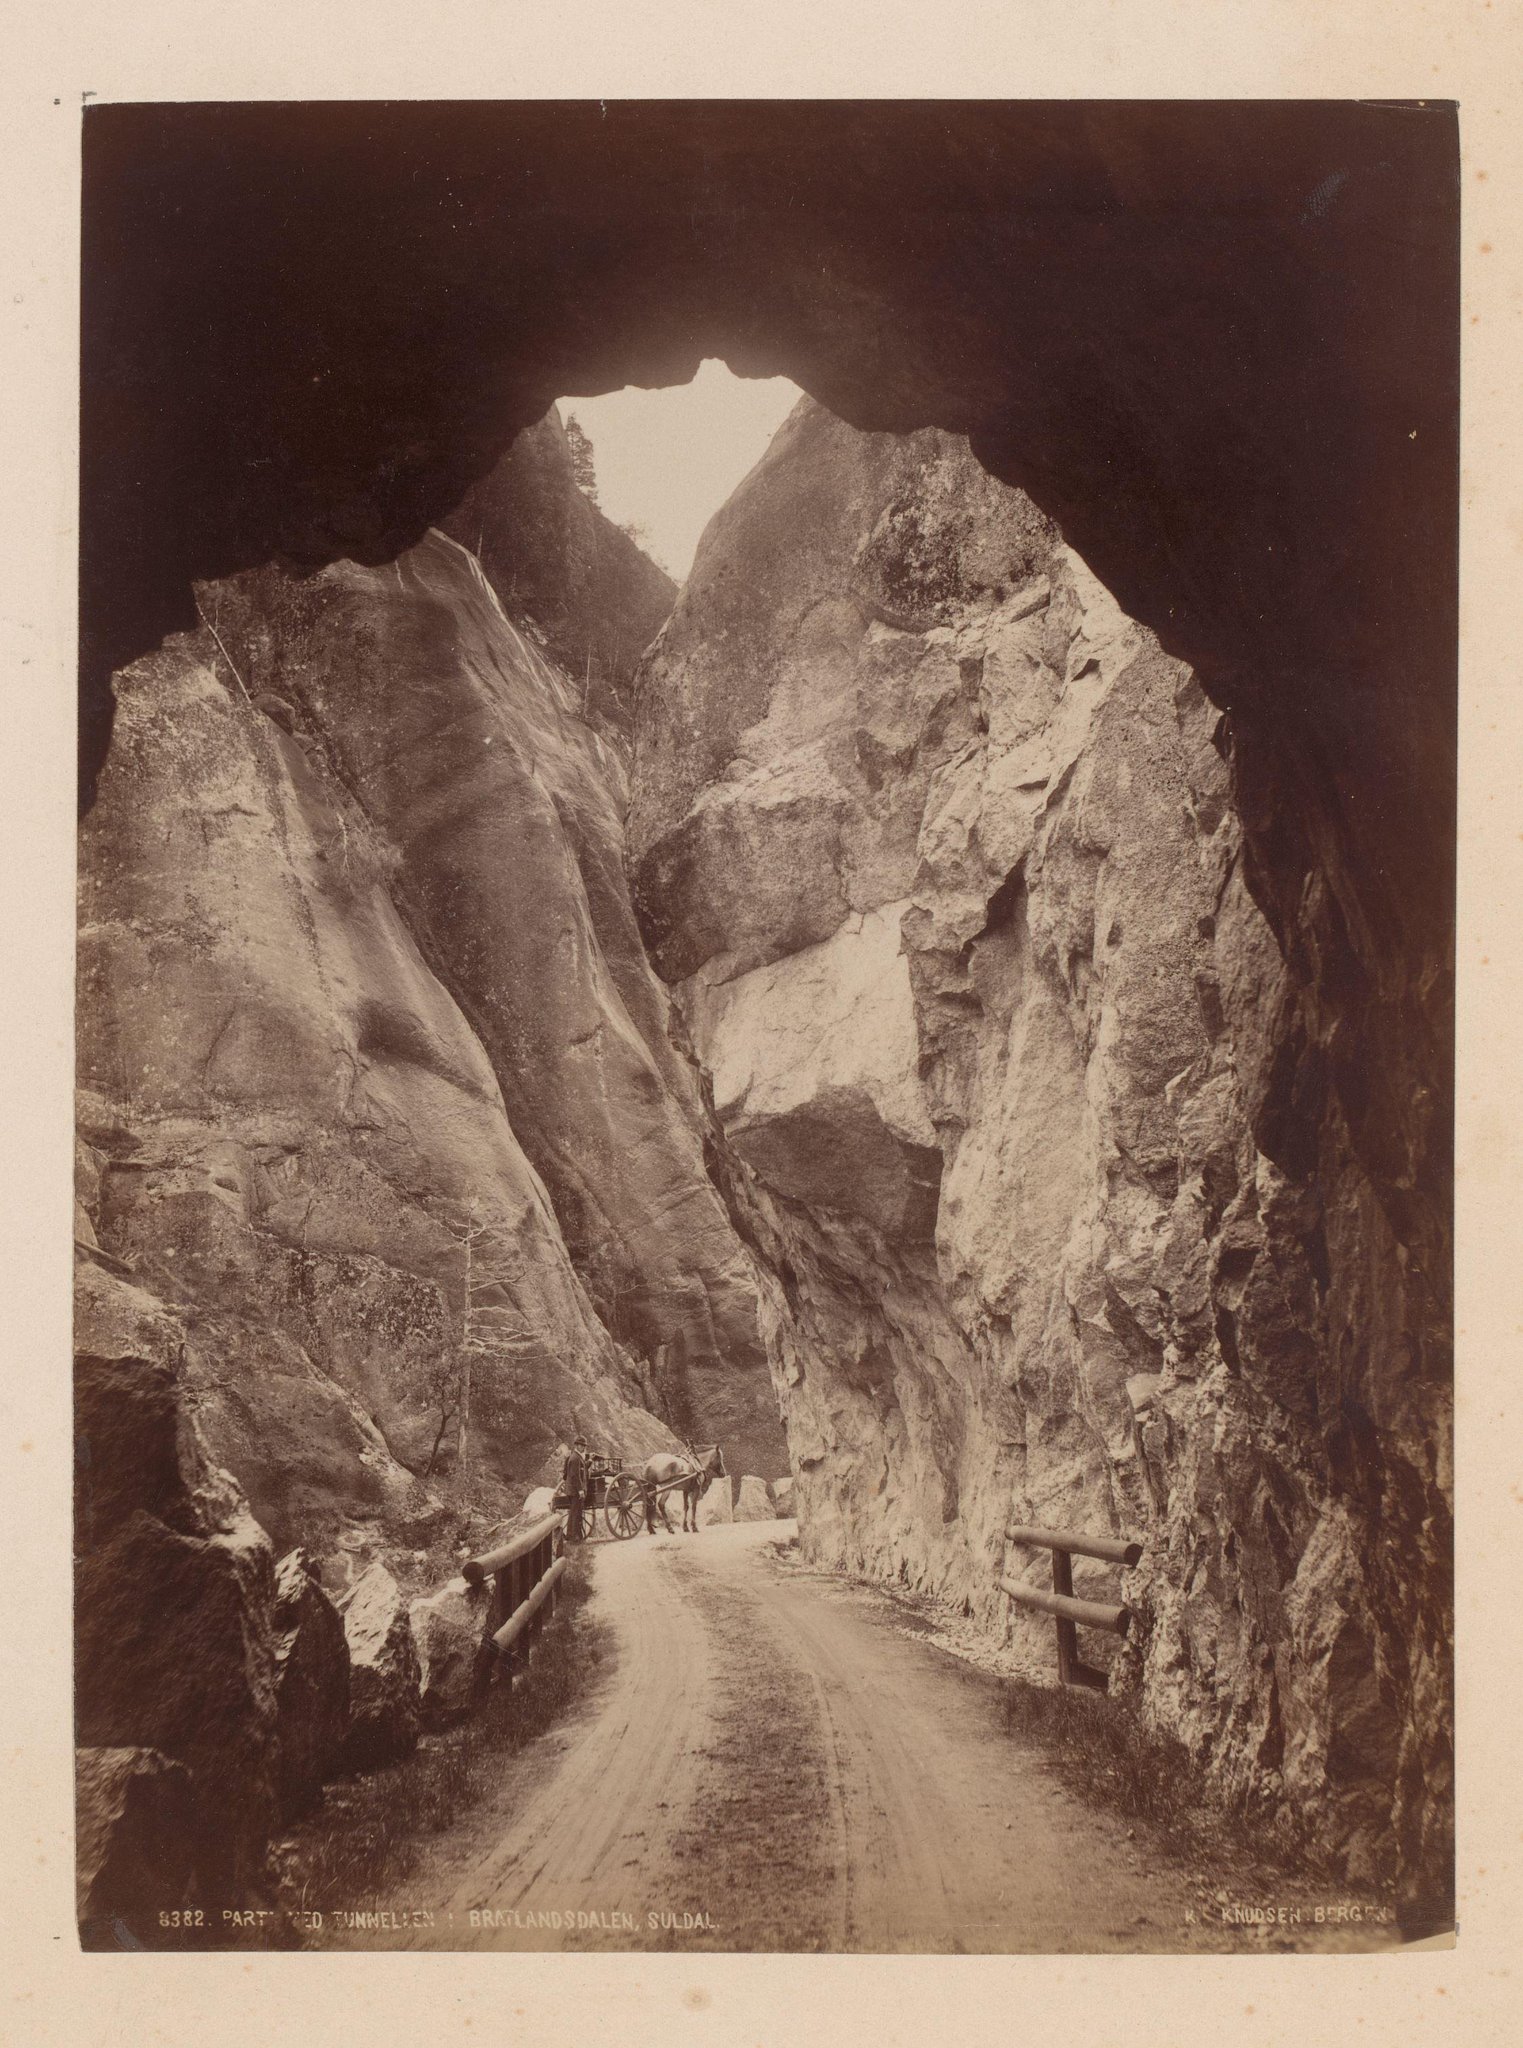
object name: photograph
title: Parti ved/ned [?] Tunnelen I Bratlandsdalen, Suldal, Noorwegen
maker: knud knudsen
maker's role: fotograaf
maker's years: 1832-1915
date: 1870-1900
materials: cardboard, photographic support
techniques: albumen print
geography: norway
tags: norway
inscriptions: number: ‘K. Knudsen, Bergen’, caption: ‘8382. PARTI NED/VED[?] TUNNELEN I BRATLANDSDALEN, SULDAL.’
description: Overhangende rots met daaronder een weg met een man met paard en wagen. Suldal is een gemeente in de Noorse provincie Rogaland.